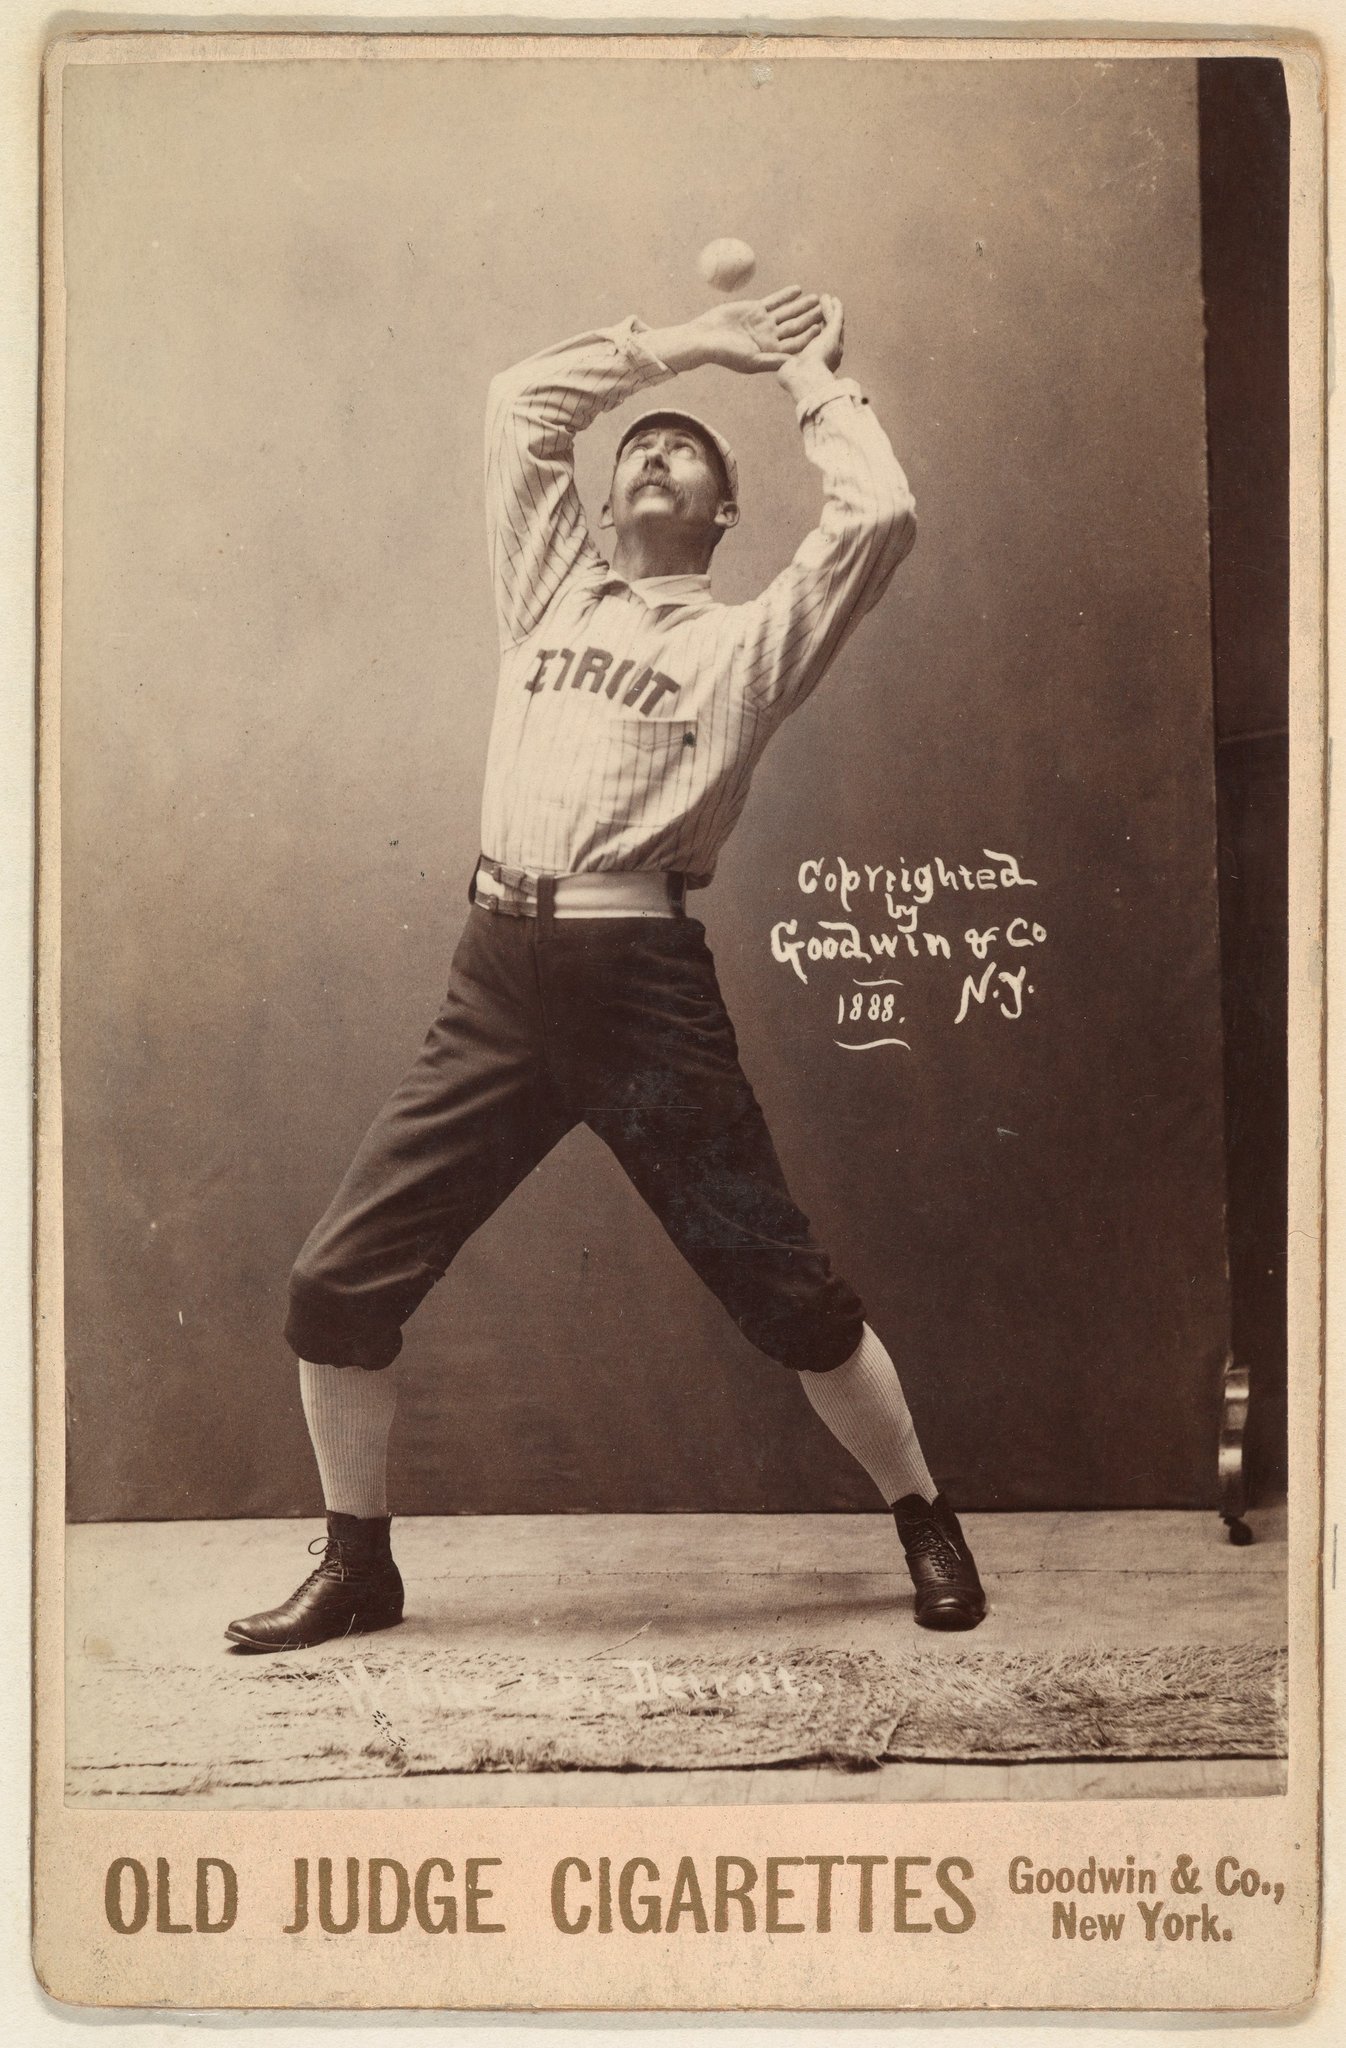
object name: baseball card, photograph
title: White, 3rd Base, Detroit, from the series Old Judge Cigarettes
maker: goodwin & company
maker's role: publisher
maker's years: 1850-1950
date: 1888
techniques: albumen print, photography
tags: men,portraits,baseball,athletes